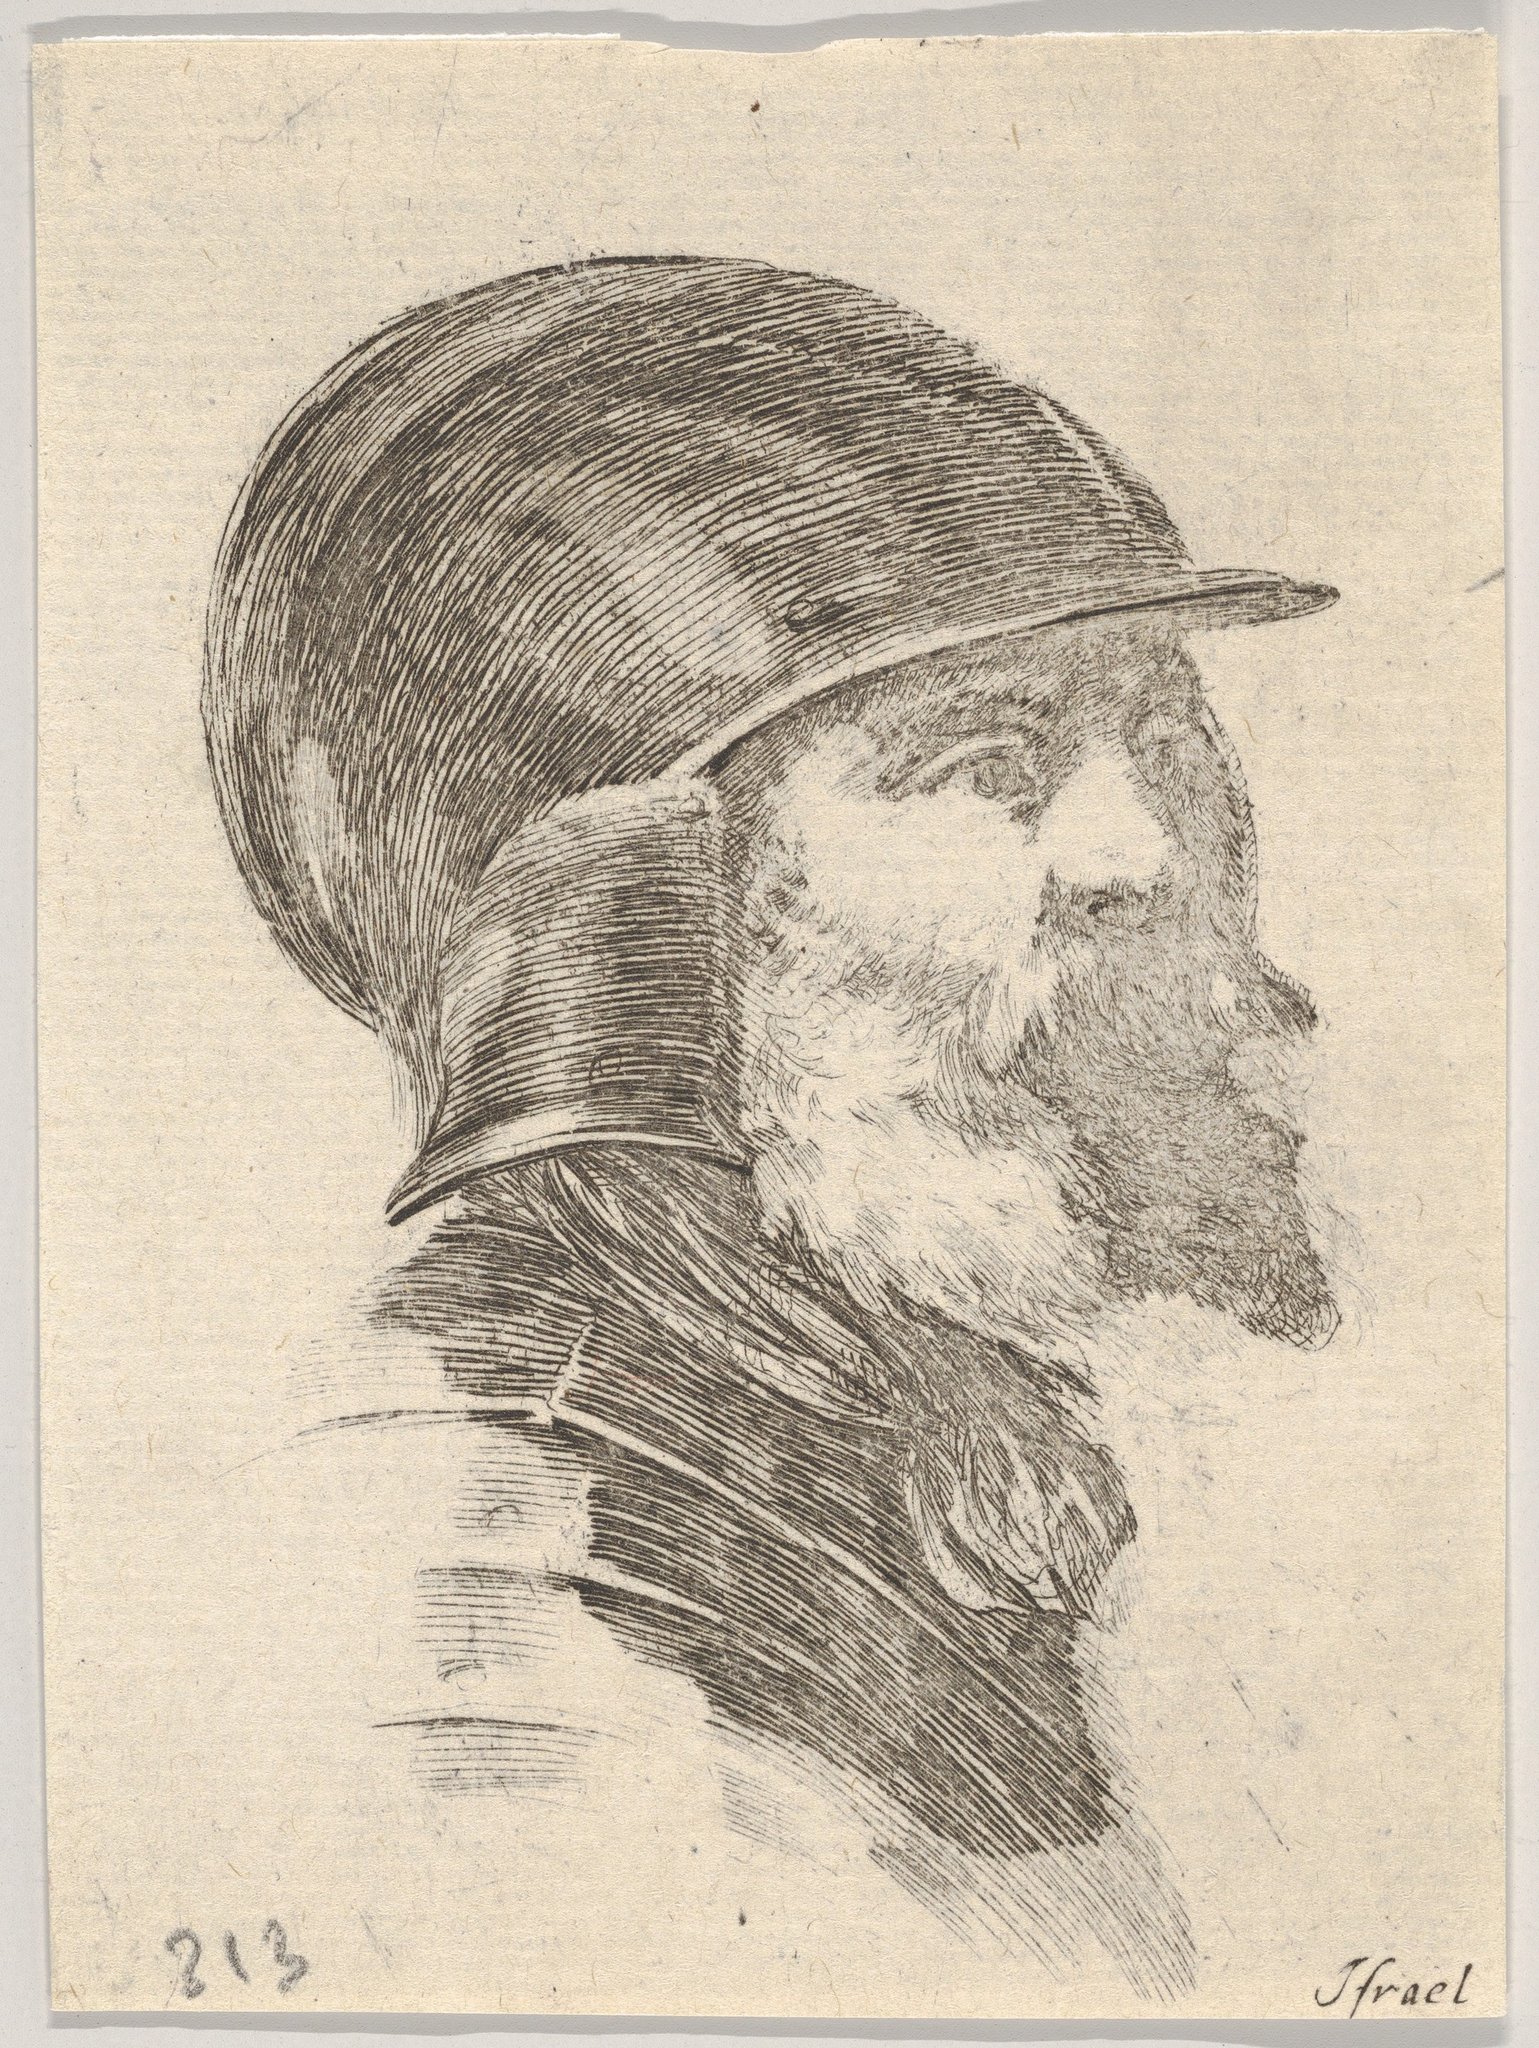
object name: print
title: Plate 6: Head of an old bearded soldier wearing a helmet, facing right, from "Various heads and figures" (Diverses têtes et figures)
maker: stefano della bella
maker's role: artist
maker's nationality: italian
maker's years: 1610-1664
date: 1650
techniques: etching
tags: soldiers,helmets,heads